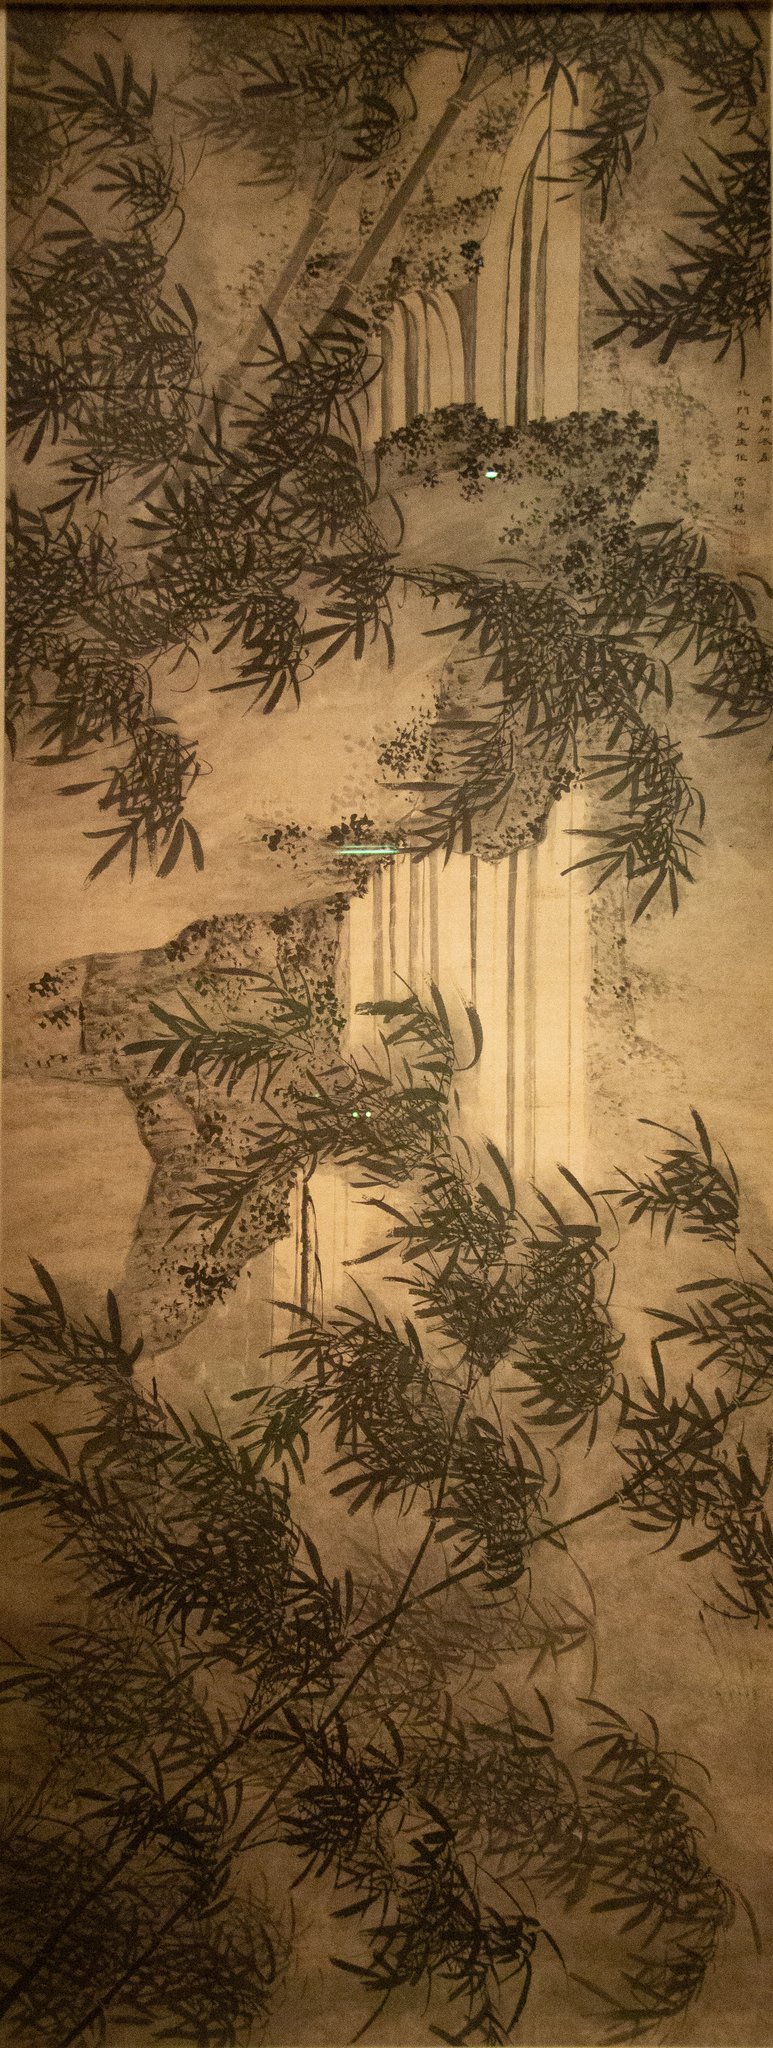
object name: hanging scroll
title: Windblown bamboo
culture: chinese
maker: yang han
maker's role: artist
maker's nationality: chinese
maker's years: 1686-1699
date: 1686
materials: ink, paper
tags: bamboo